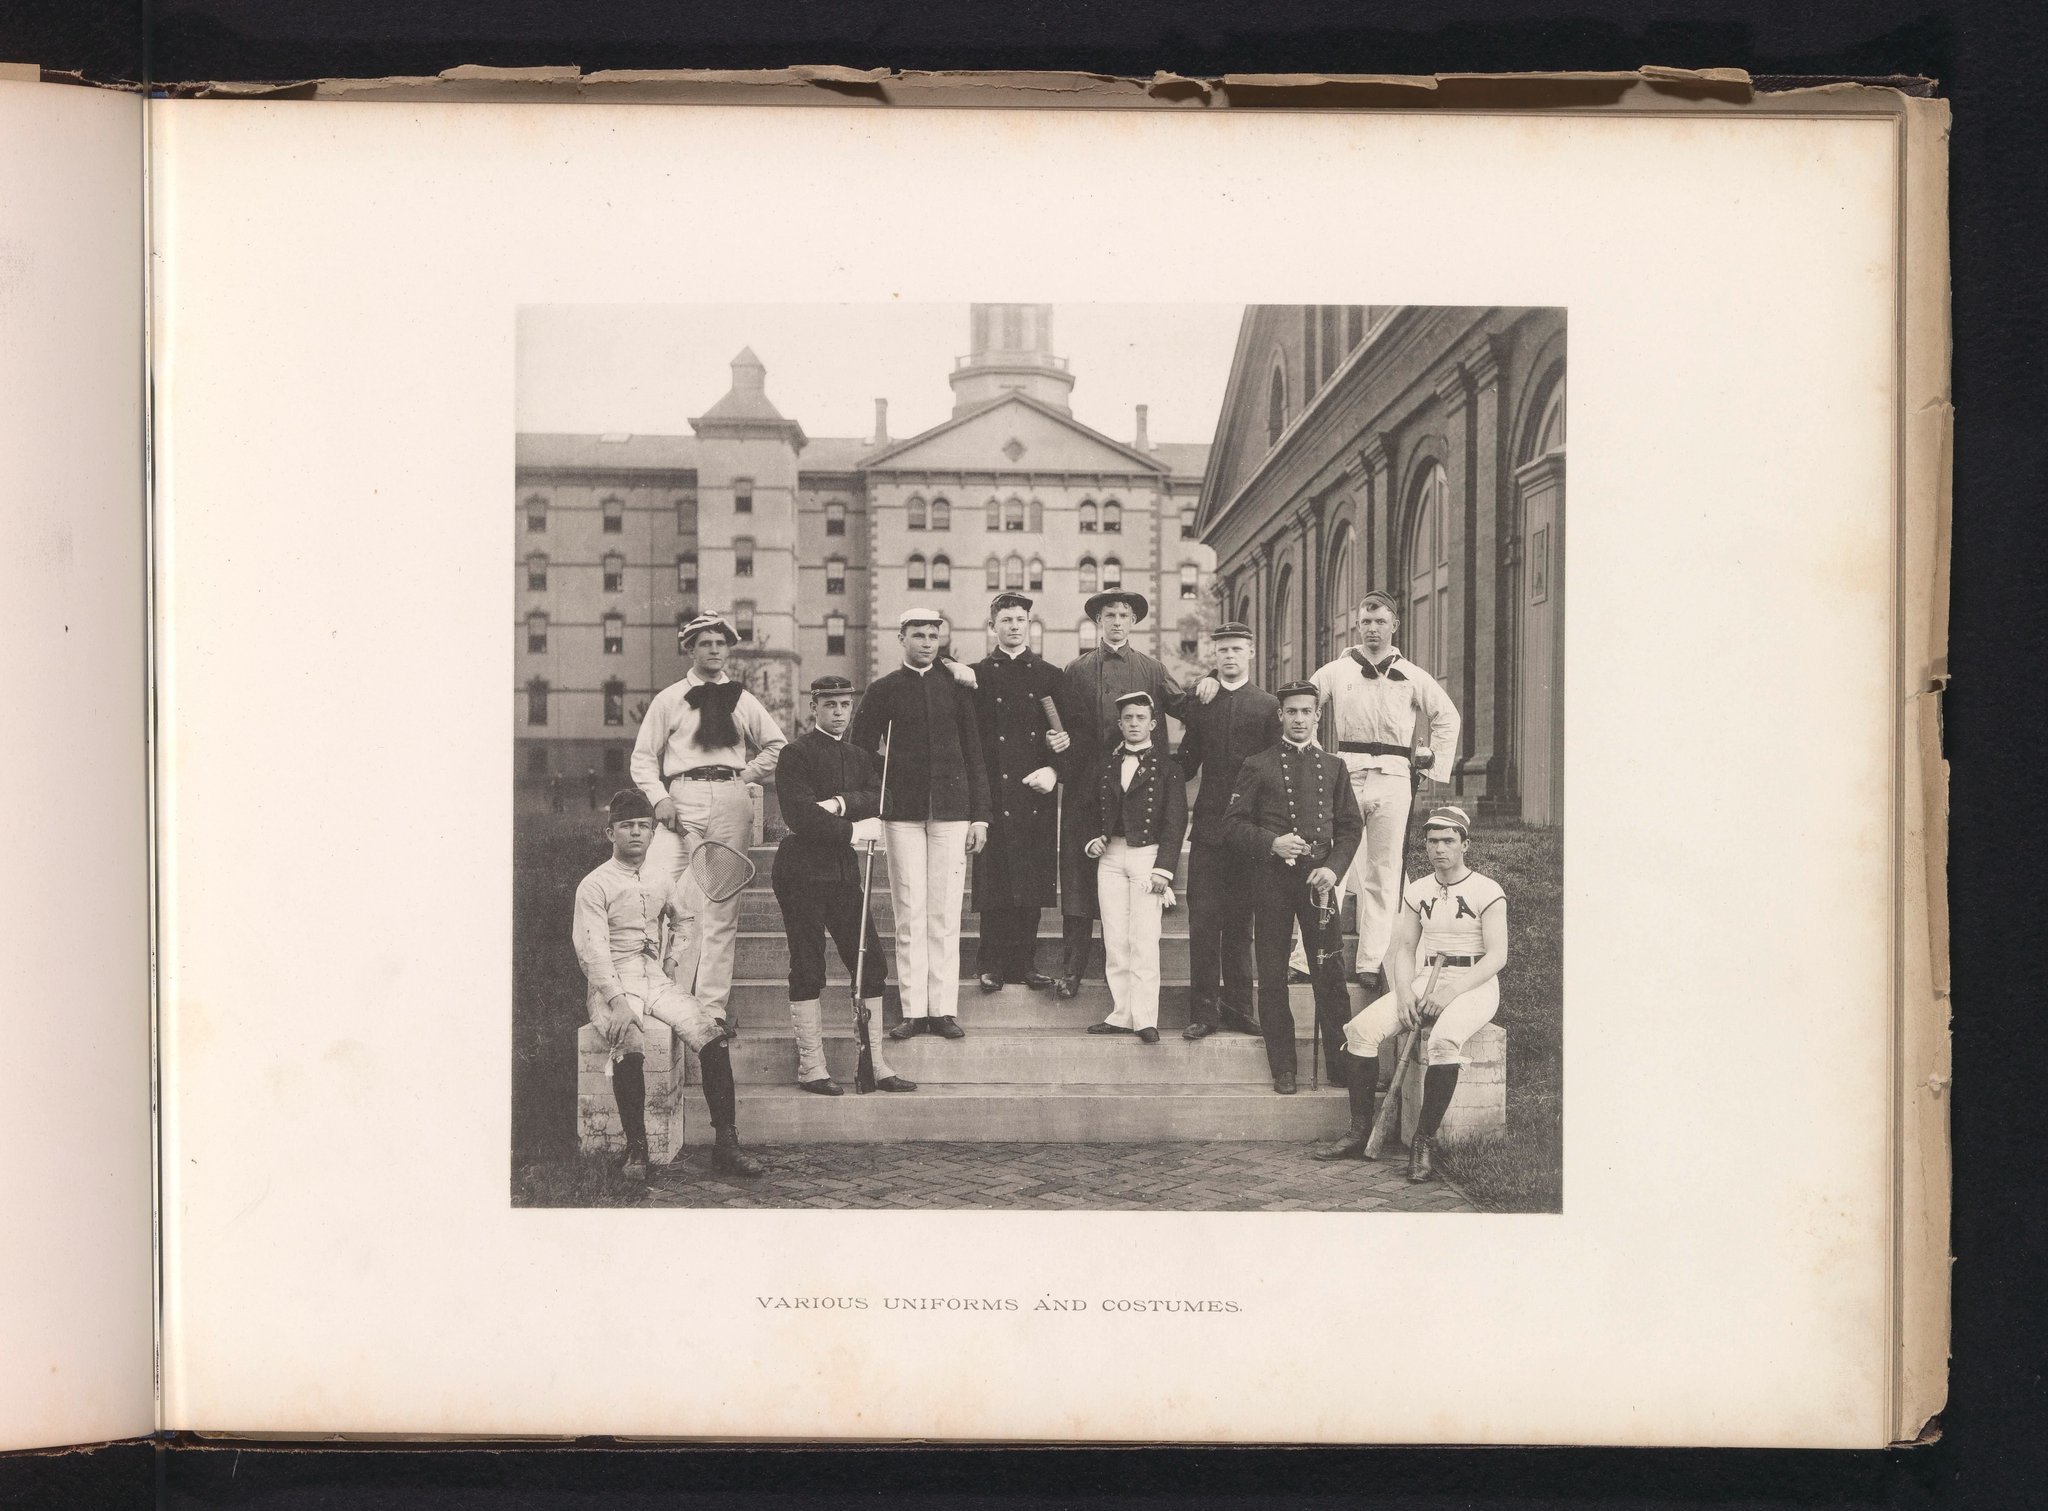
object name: page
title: Various uniforms and costumes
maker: edward h. hart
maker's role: publisher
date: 1885-1890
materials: paper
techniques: photograph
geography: new york city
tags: officer, (military) uniforms, anonymous historical persons portrayed in a group, in a group-portrait